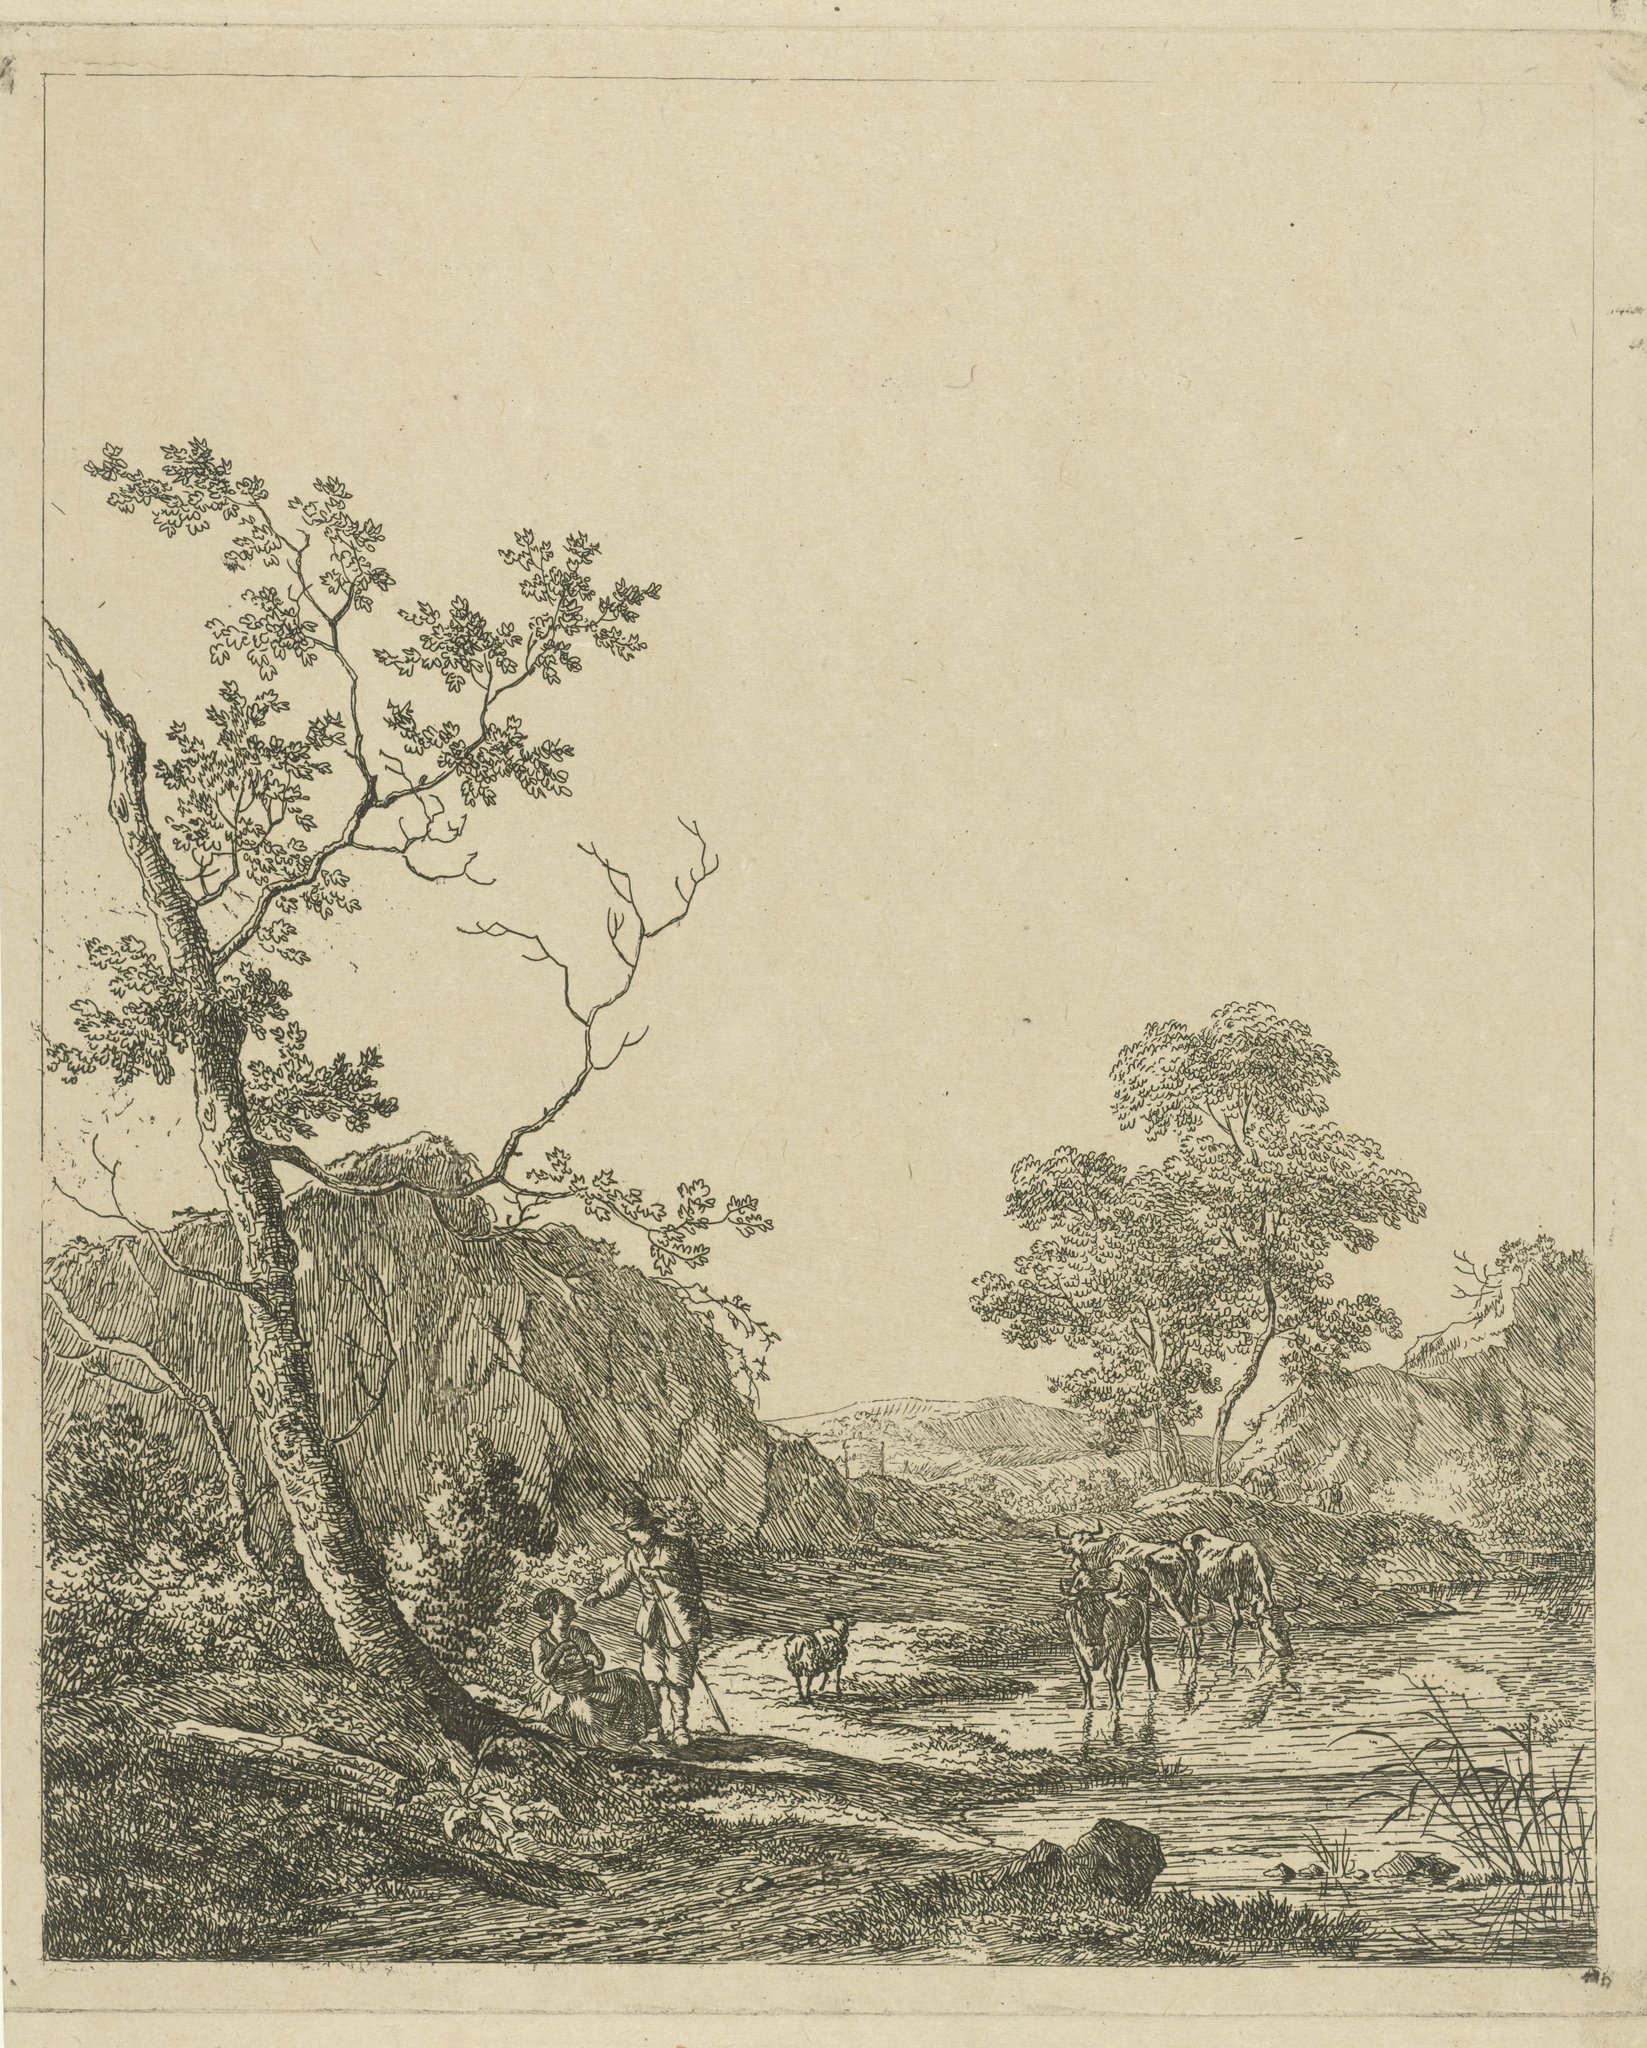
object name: print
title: Landschap met vee in rivier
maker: johannes janson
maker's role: draughtsman, painter, print maker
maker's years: 1729-1784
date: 1761-1784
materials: paper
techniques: etching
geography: leiden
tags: pastorals, arcadian scenes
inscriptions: collector's mark: Lugt 240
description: Heuvelachtig landschap met koeien in rivier en een schaap op een pad. Bij de boom links een zittende vrouw in gesprek met een man. Op de achtergrond een toren. Vóór de lucht.